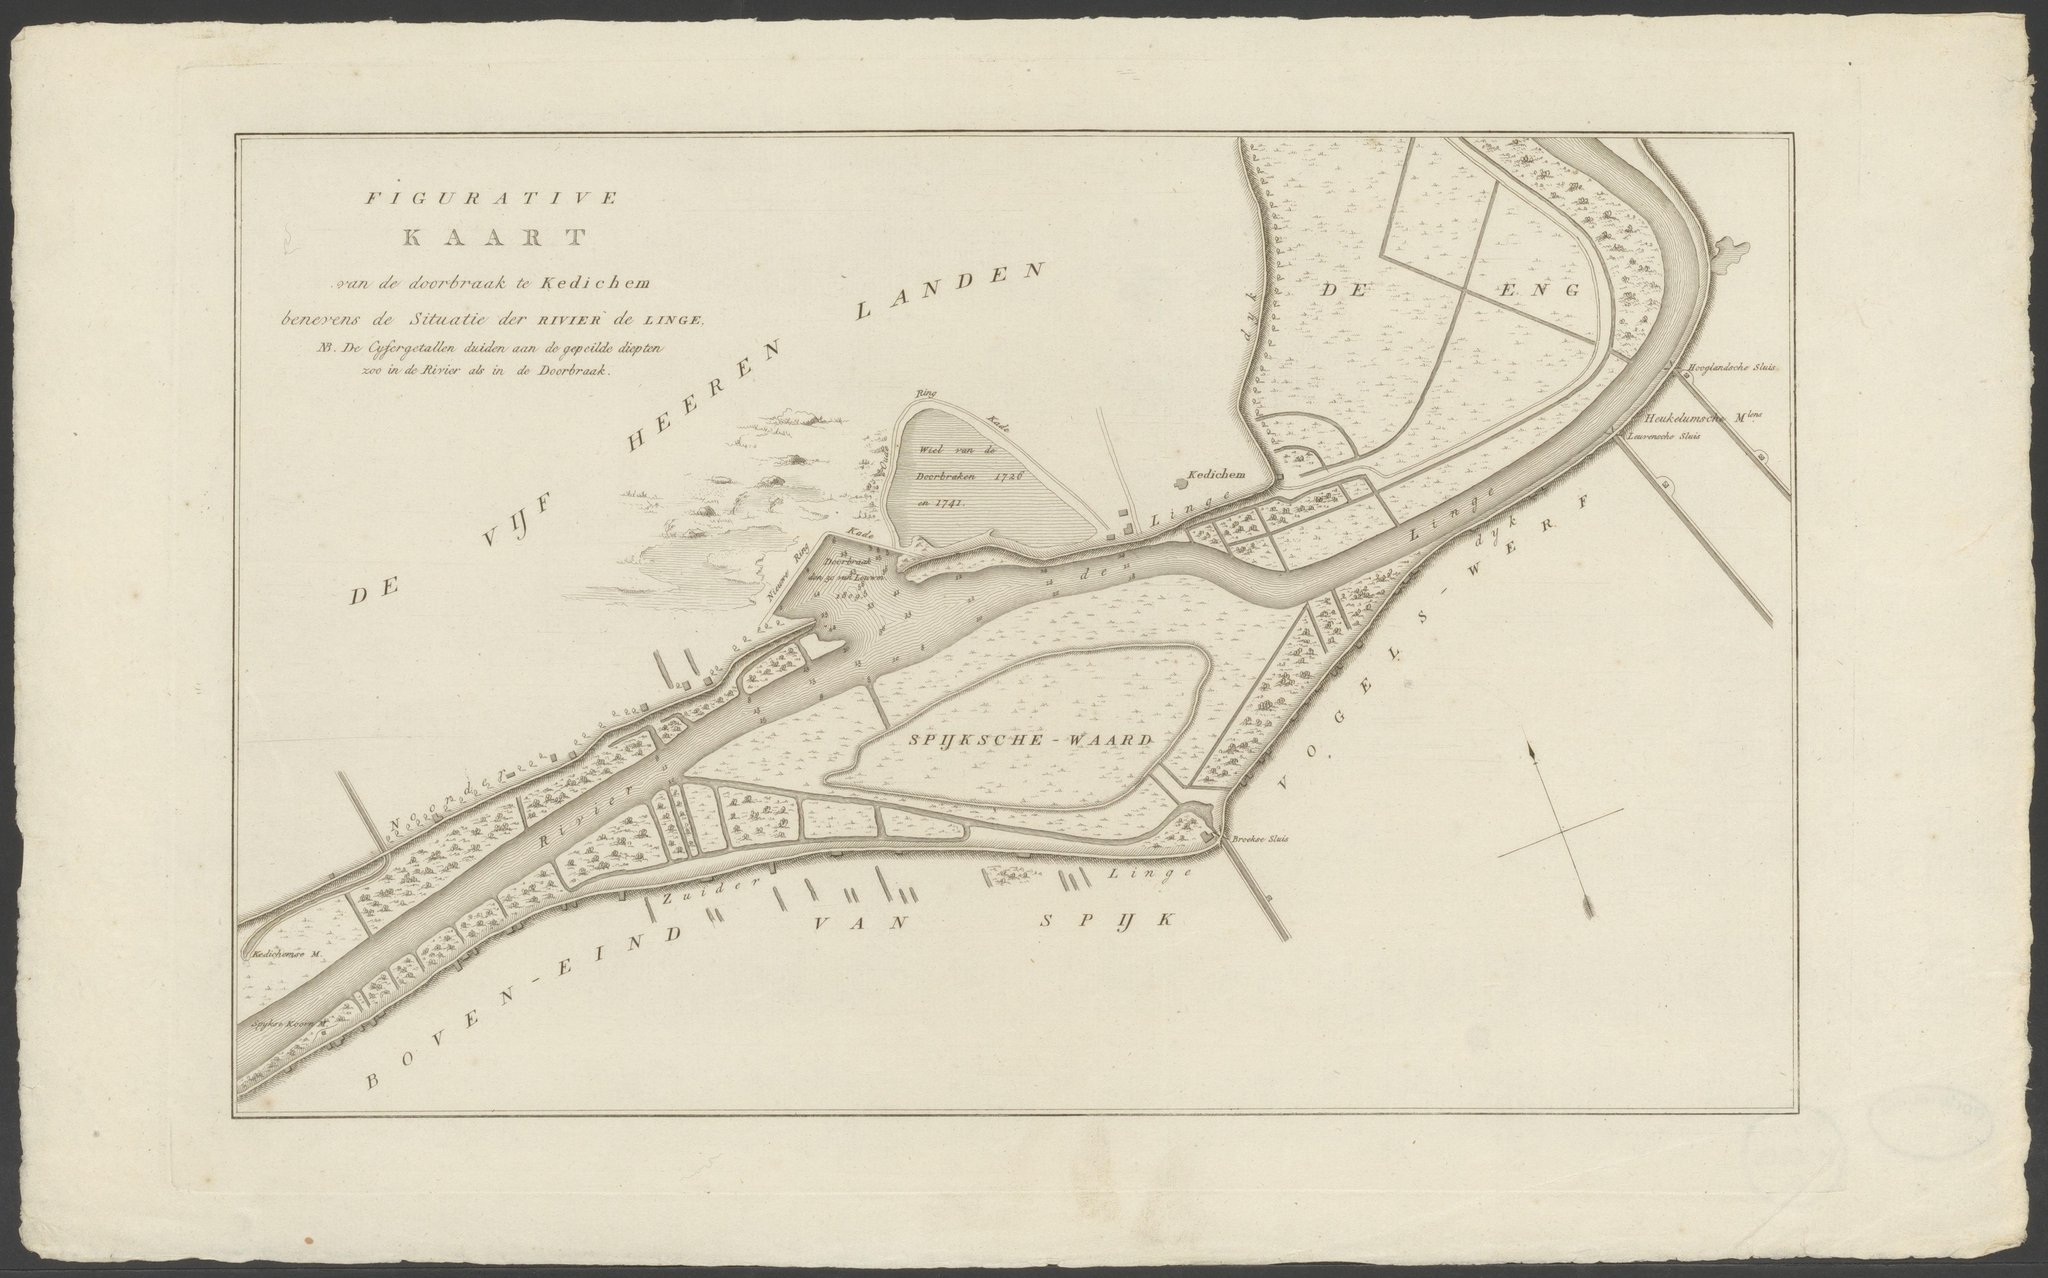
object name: map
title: Figurative kaart van de doorbraak te Kedichem benevens de Situatie der Rivier de Linge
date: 1809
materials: paper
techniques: engraving, etching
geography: amsterdam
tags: dike-break, flood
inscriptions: stamp, collector's mark: Lugt 1641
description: Prent ook gebruikt ter illustratie van: Ewijk, Hendrik. Geschiedkundig verslag der dijkbreuken en overstroomingen, langs de rivieren in het Koningrijk Holland, voorgevallen in louwmaand MDCCCIX. 3 dln. Amsterdam: Johannes Allart en Jacobus Ruys, 1809.